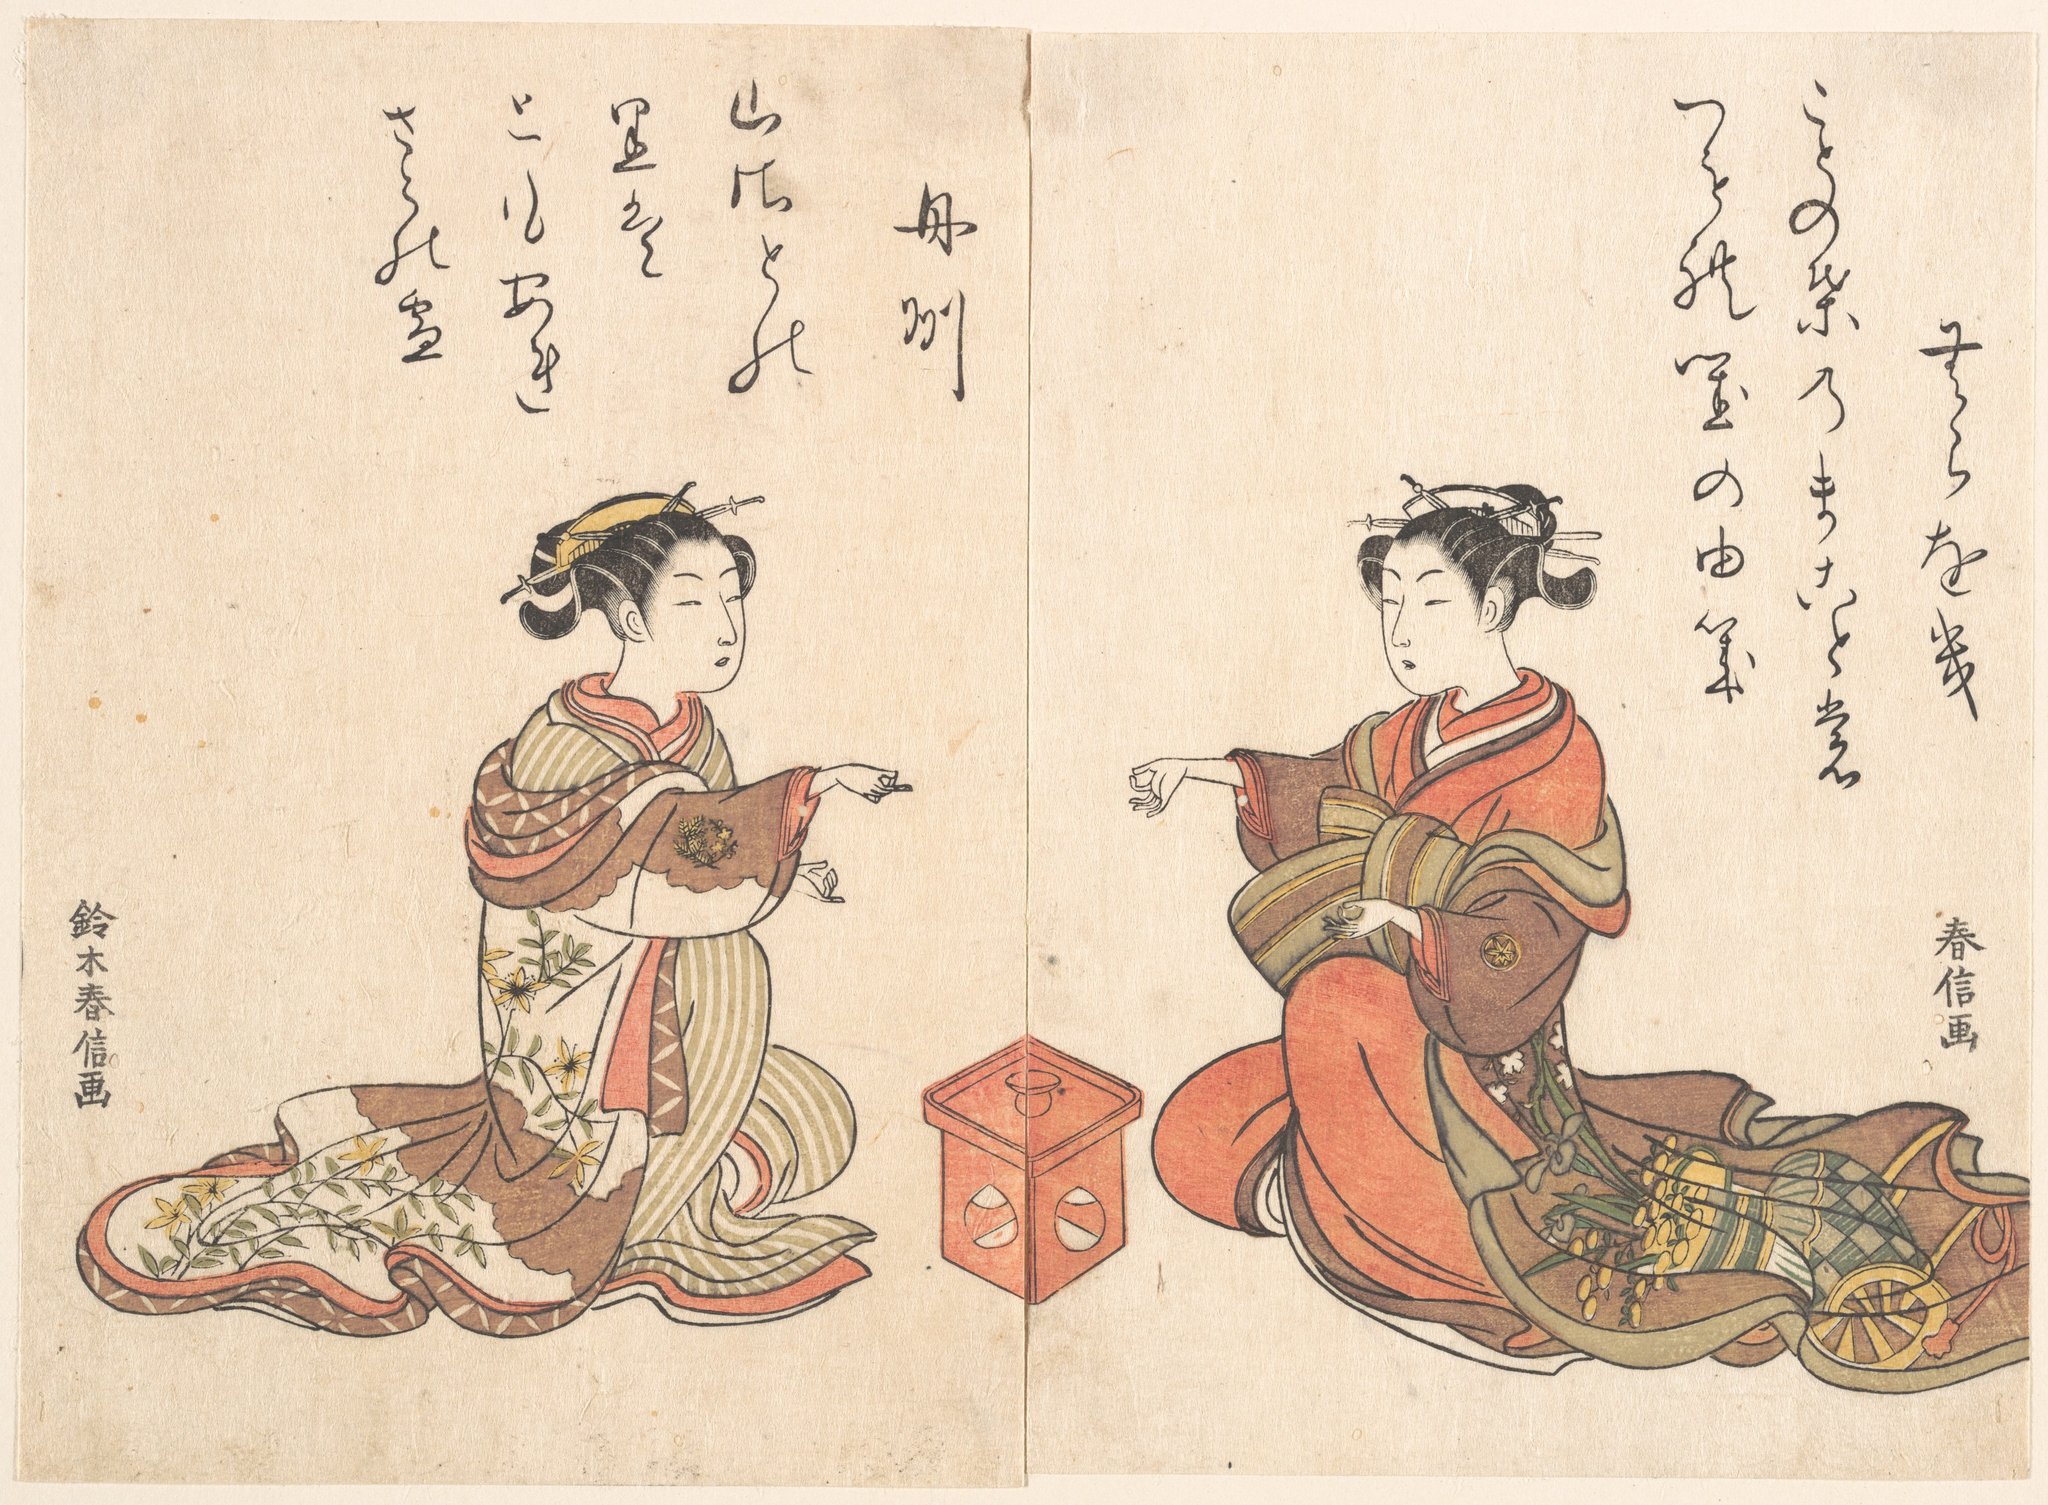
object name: print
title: Two Girls Play the Finger Game of Kitsume Ken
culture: japanese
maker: suzuki harunobu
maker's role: artist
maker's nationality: japanese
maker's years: 1725-1770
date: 1725-1770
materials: ink, paper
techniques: woodblock print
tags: girls,playing,games